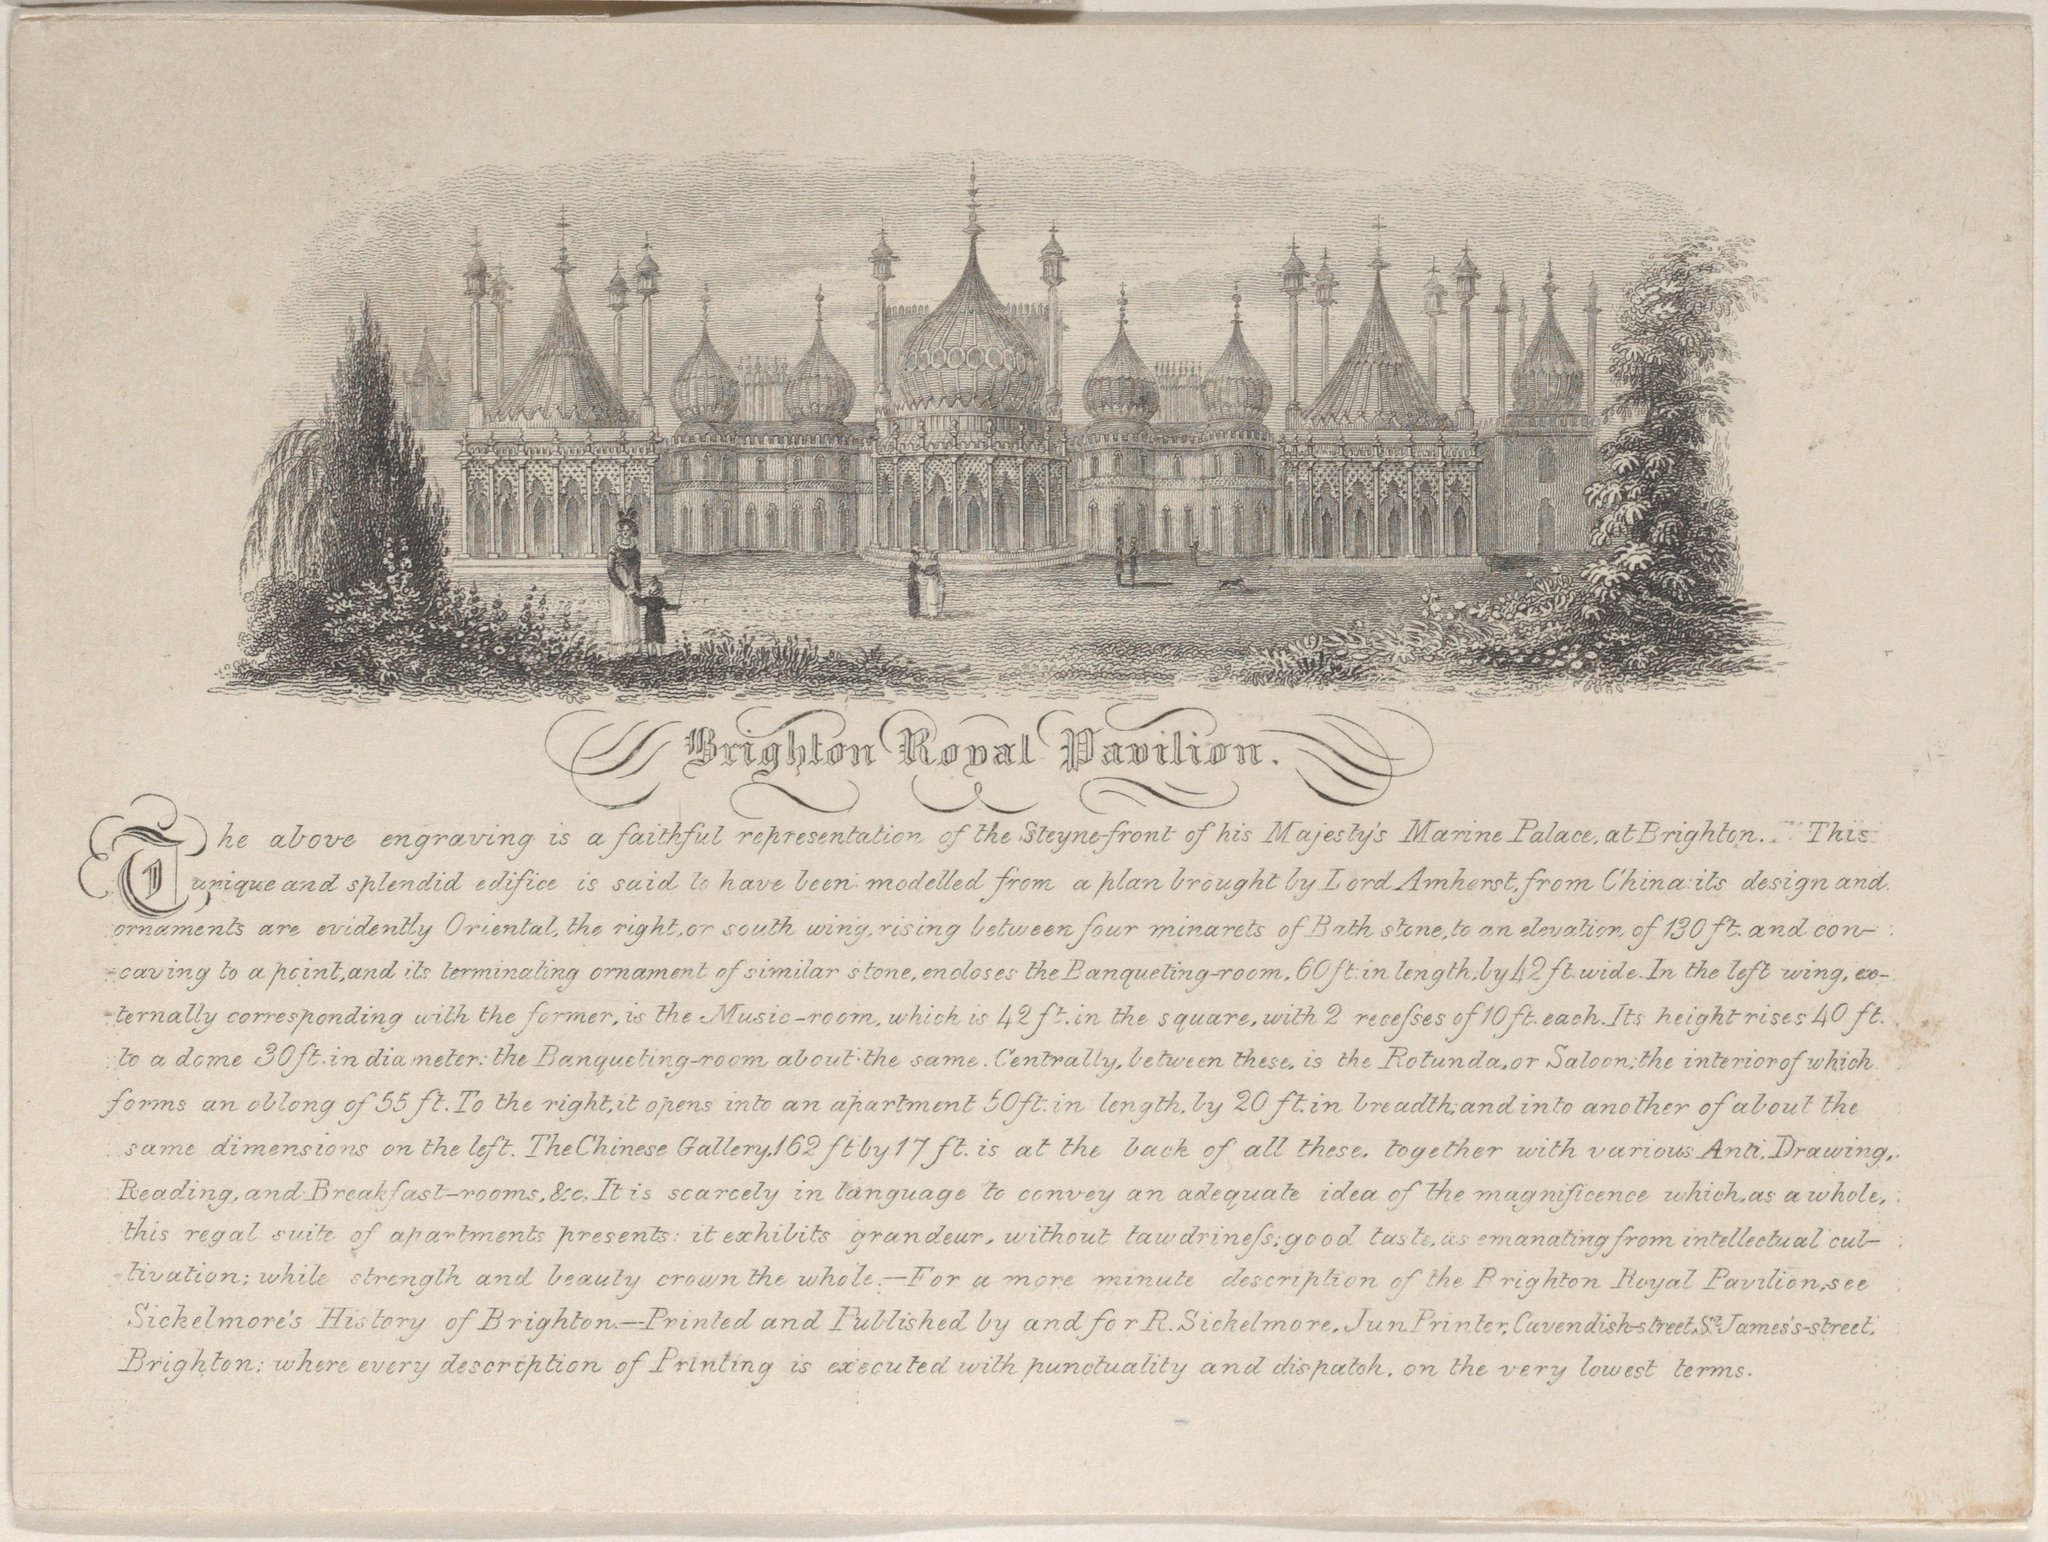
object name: print, trade card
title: Trade Card for R. Sickelmore, Printer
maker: richard sickelmore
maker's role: artist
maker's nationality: british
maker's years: 1800-1900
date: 1801-1900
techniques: engraving